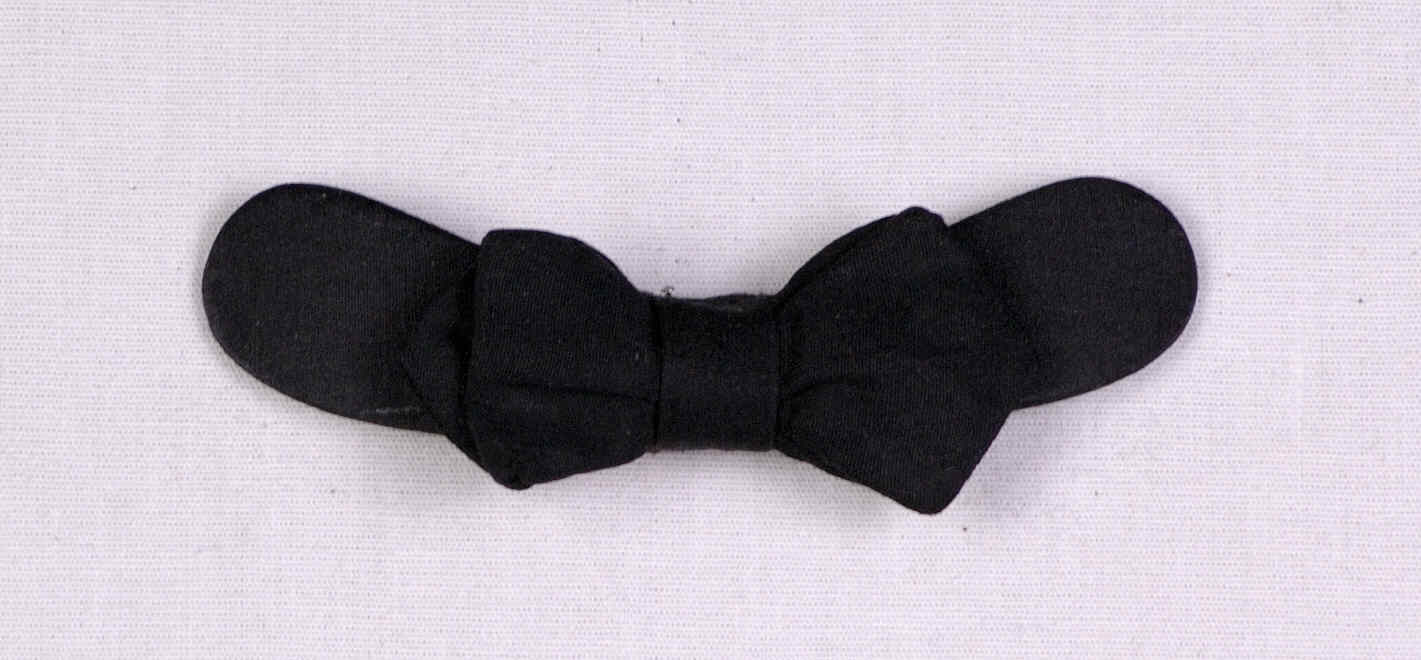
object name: evening bow tie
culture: american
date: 1890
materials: silk